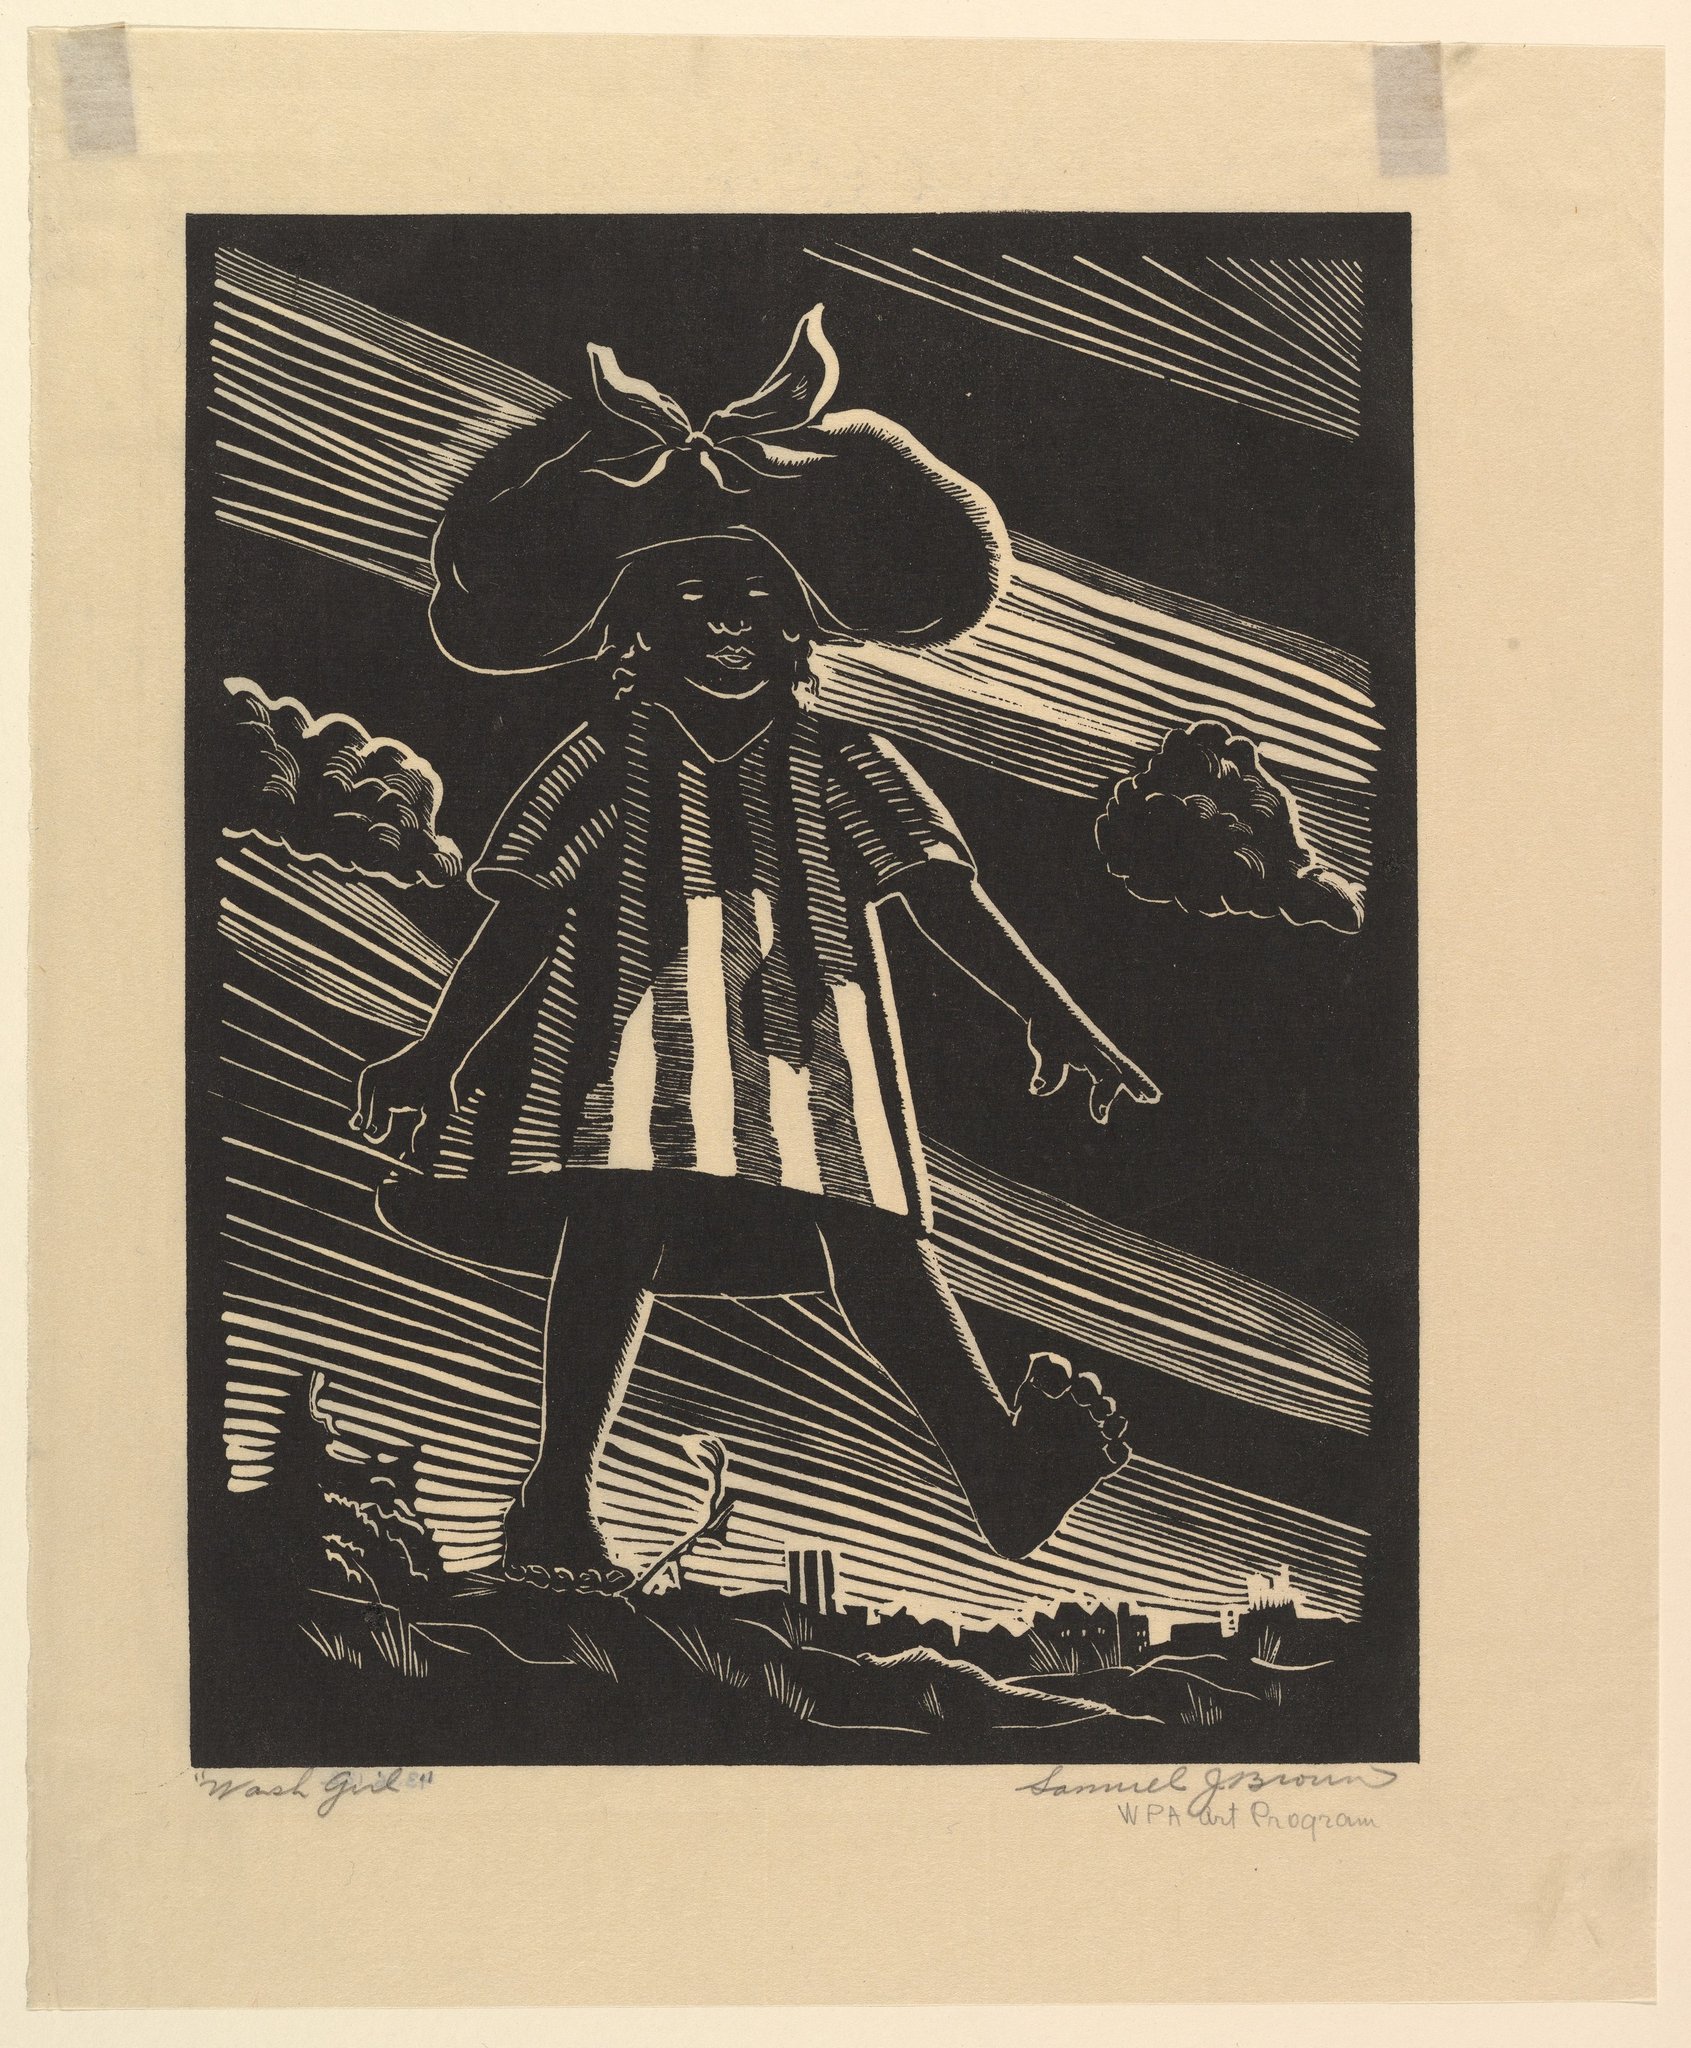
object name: print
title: Wash Girl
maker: samuel joseph brown, jr.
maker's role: artist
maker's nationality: american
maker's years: 1907-1994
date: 1935-1943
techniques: linocut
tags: girls